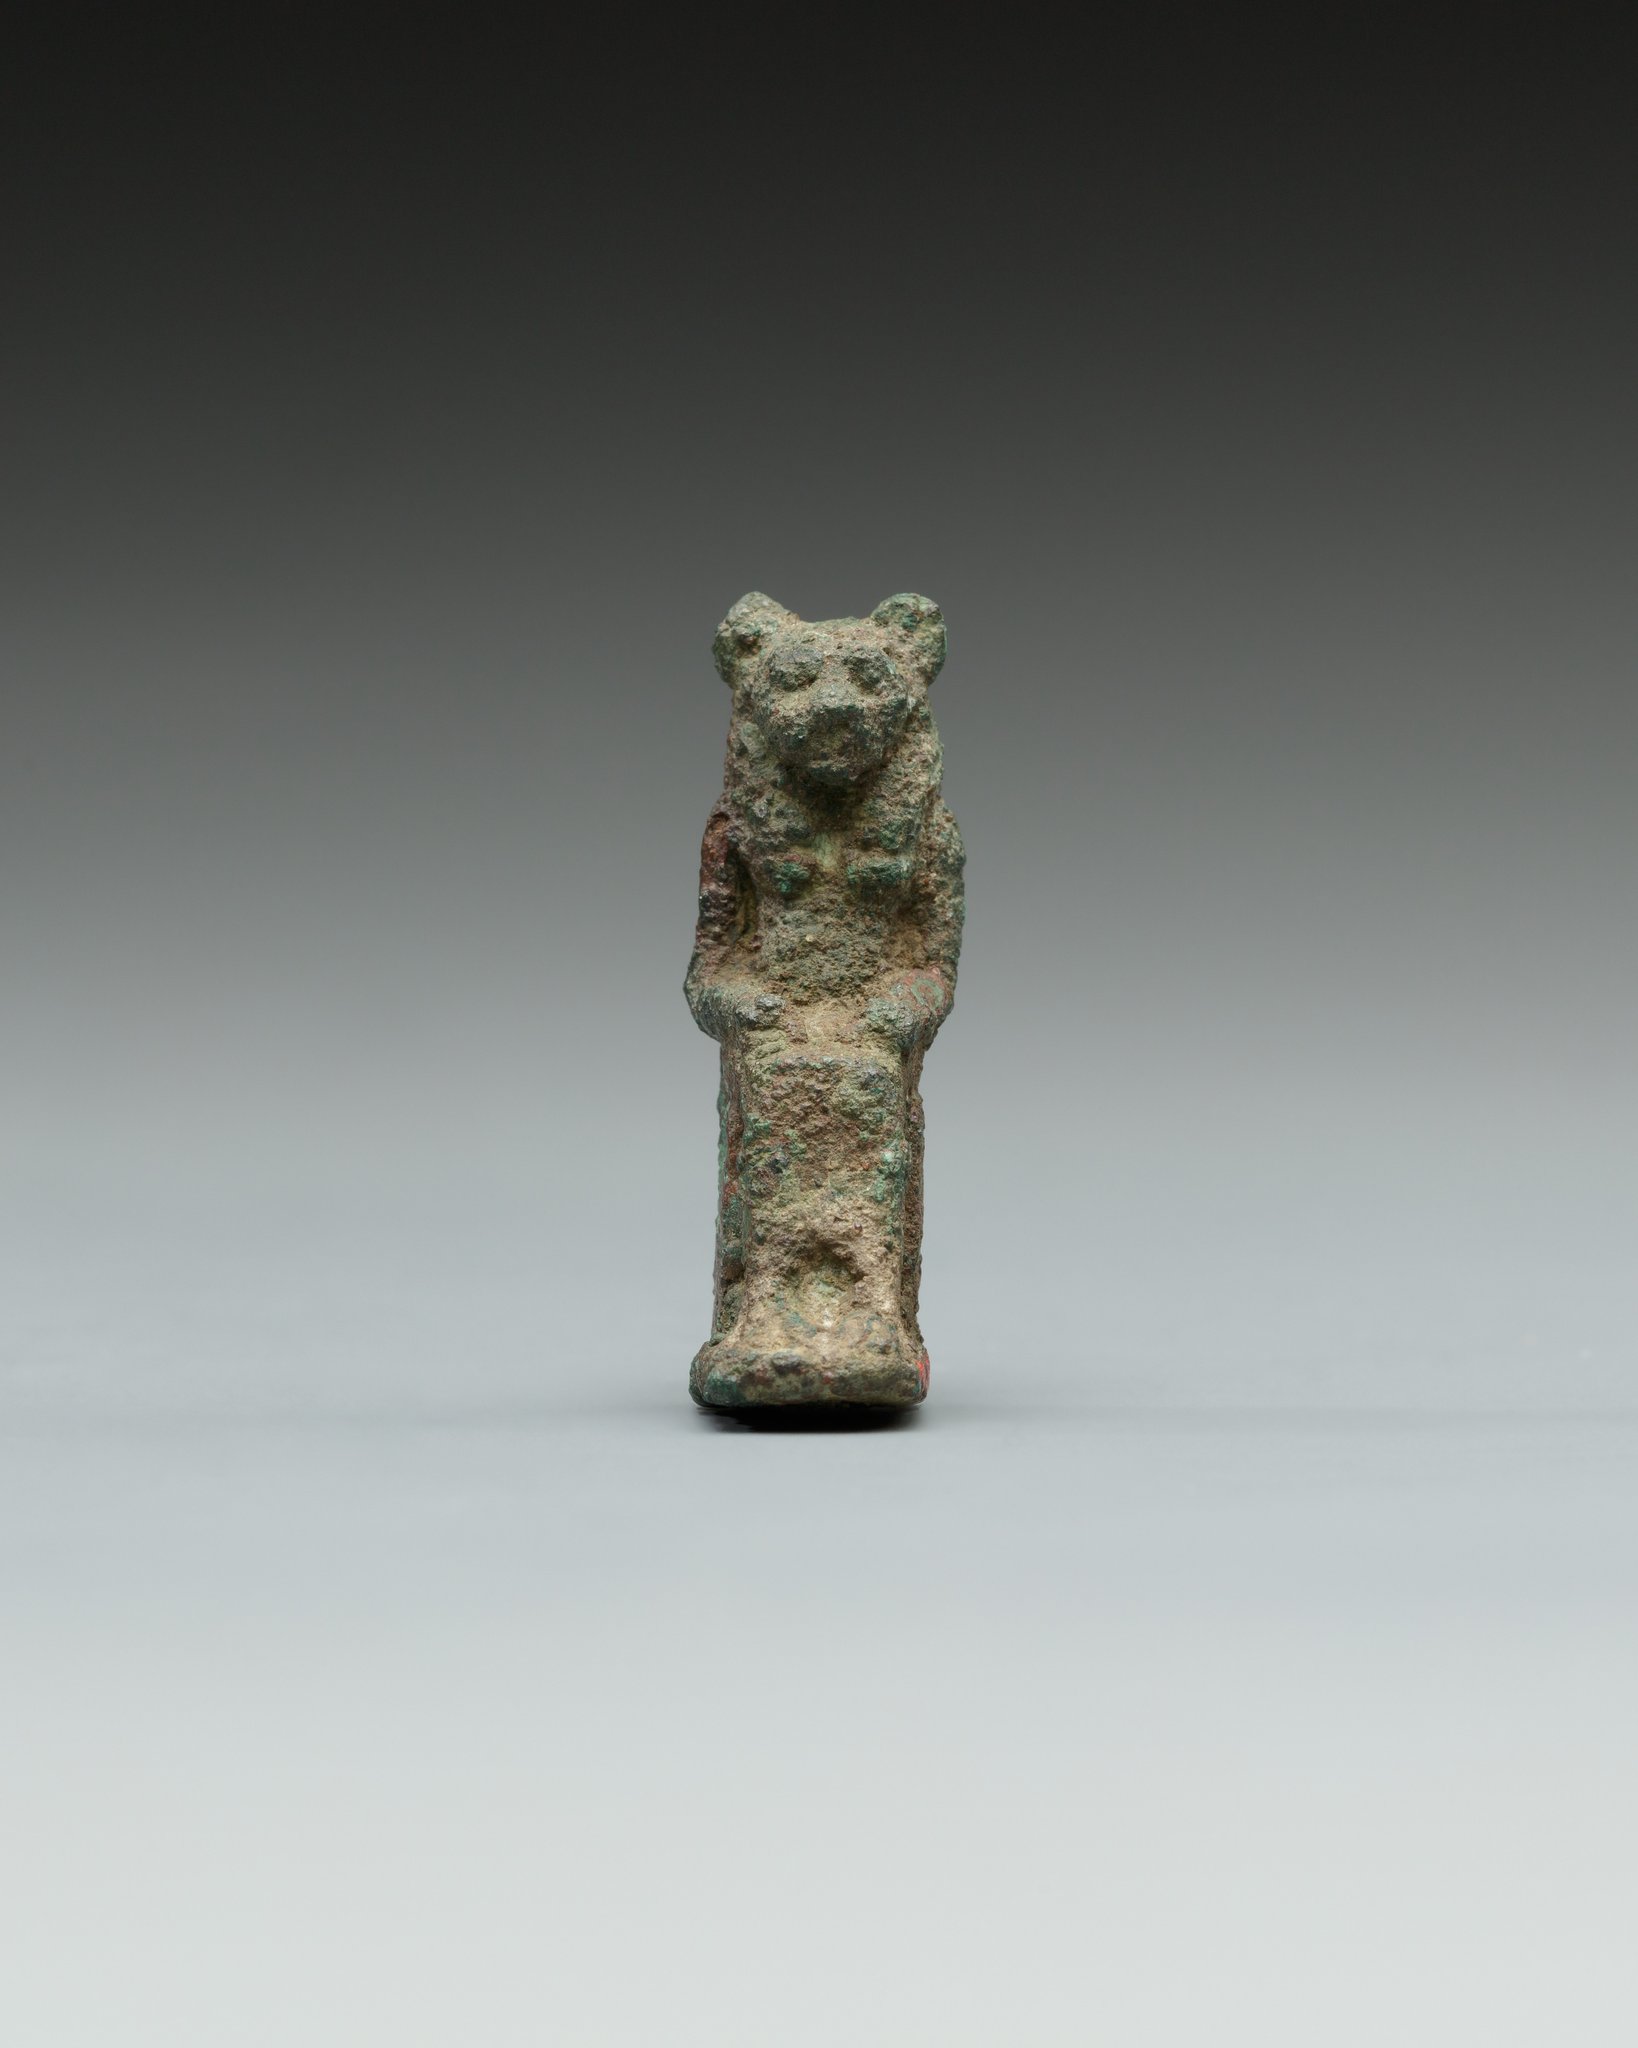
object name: statuette, lion headed goddess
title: Lion-headed goddess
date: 664-630 BCE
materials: alloy, bronze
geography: egypt